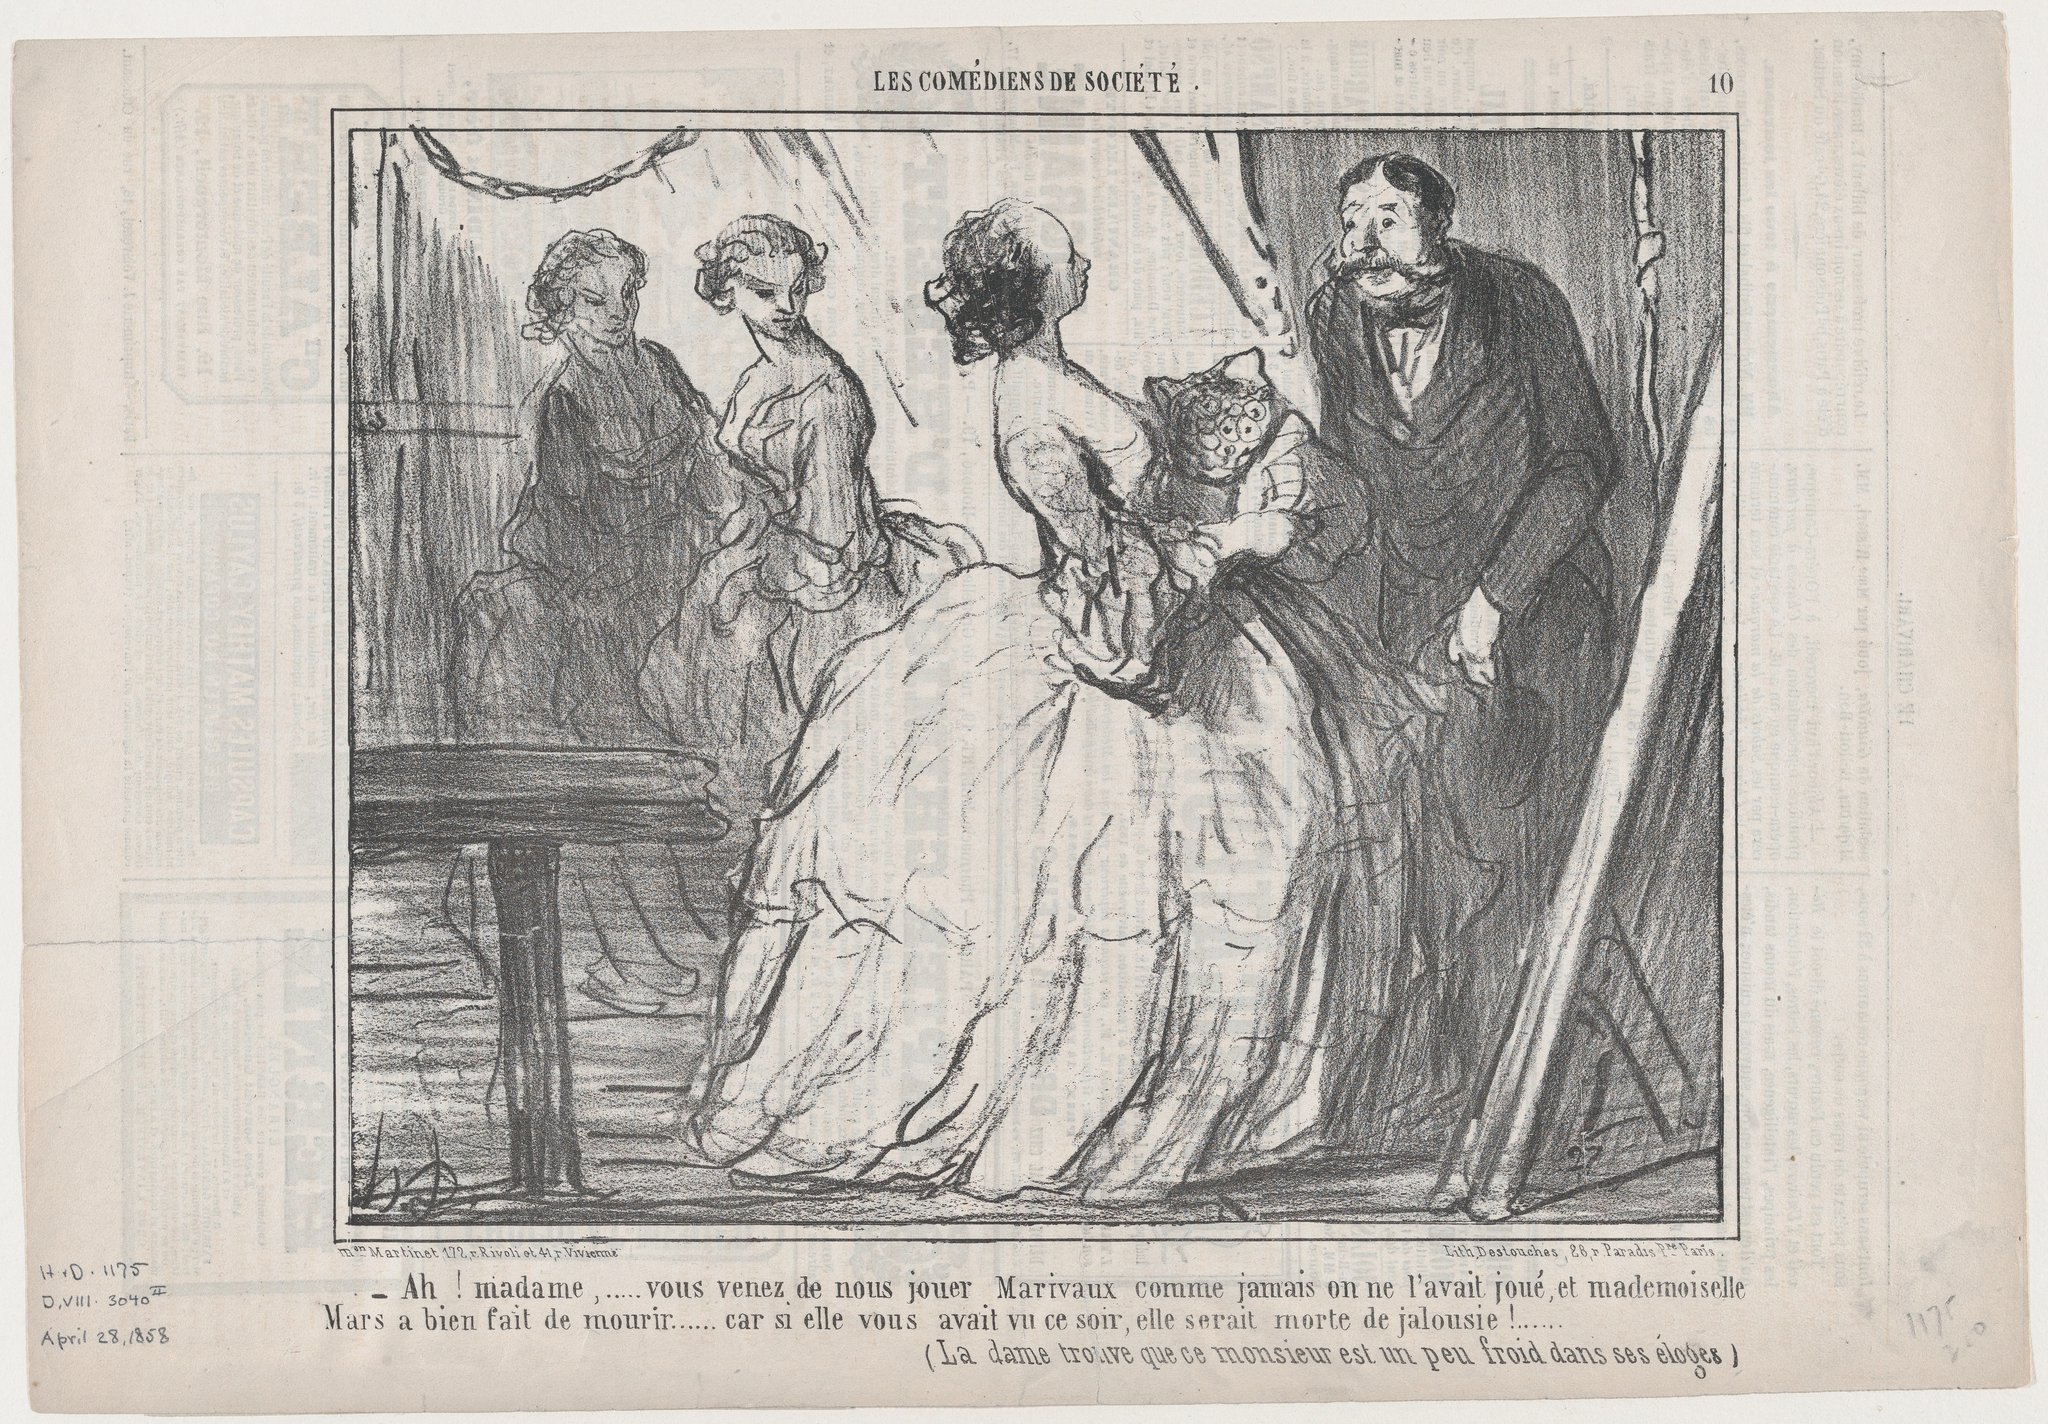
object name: print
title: Ah! madame,... vous venez de nous jouer Marivaux comme jamais on ne l'avait joué..., from "Les Comediens de Société"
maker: honoré daumier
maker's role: artist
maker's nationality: french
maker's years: 1808-1879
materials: paper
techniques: lithograph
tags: men,women